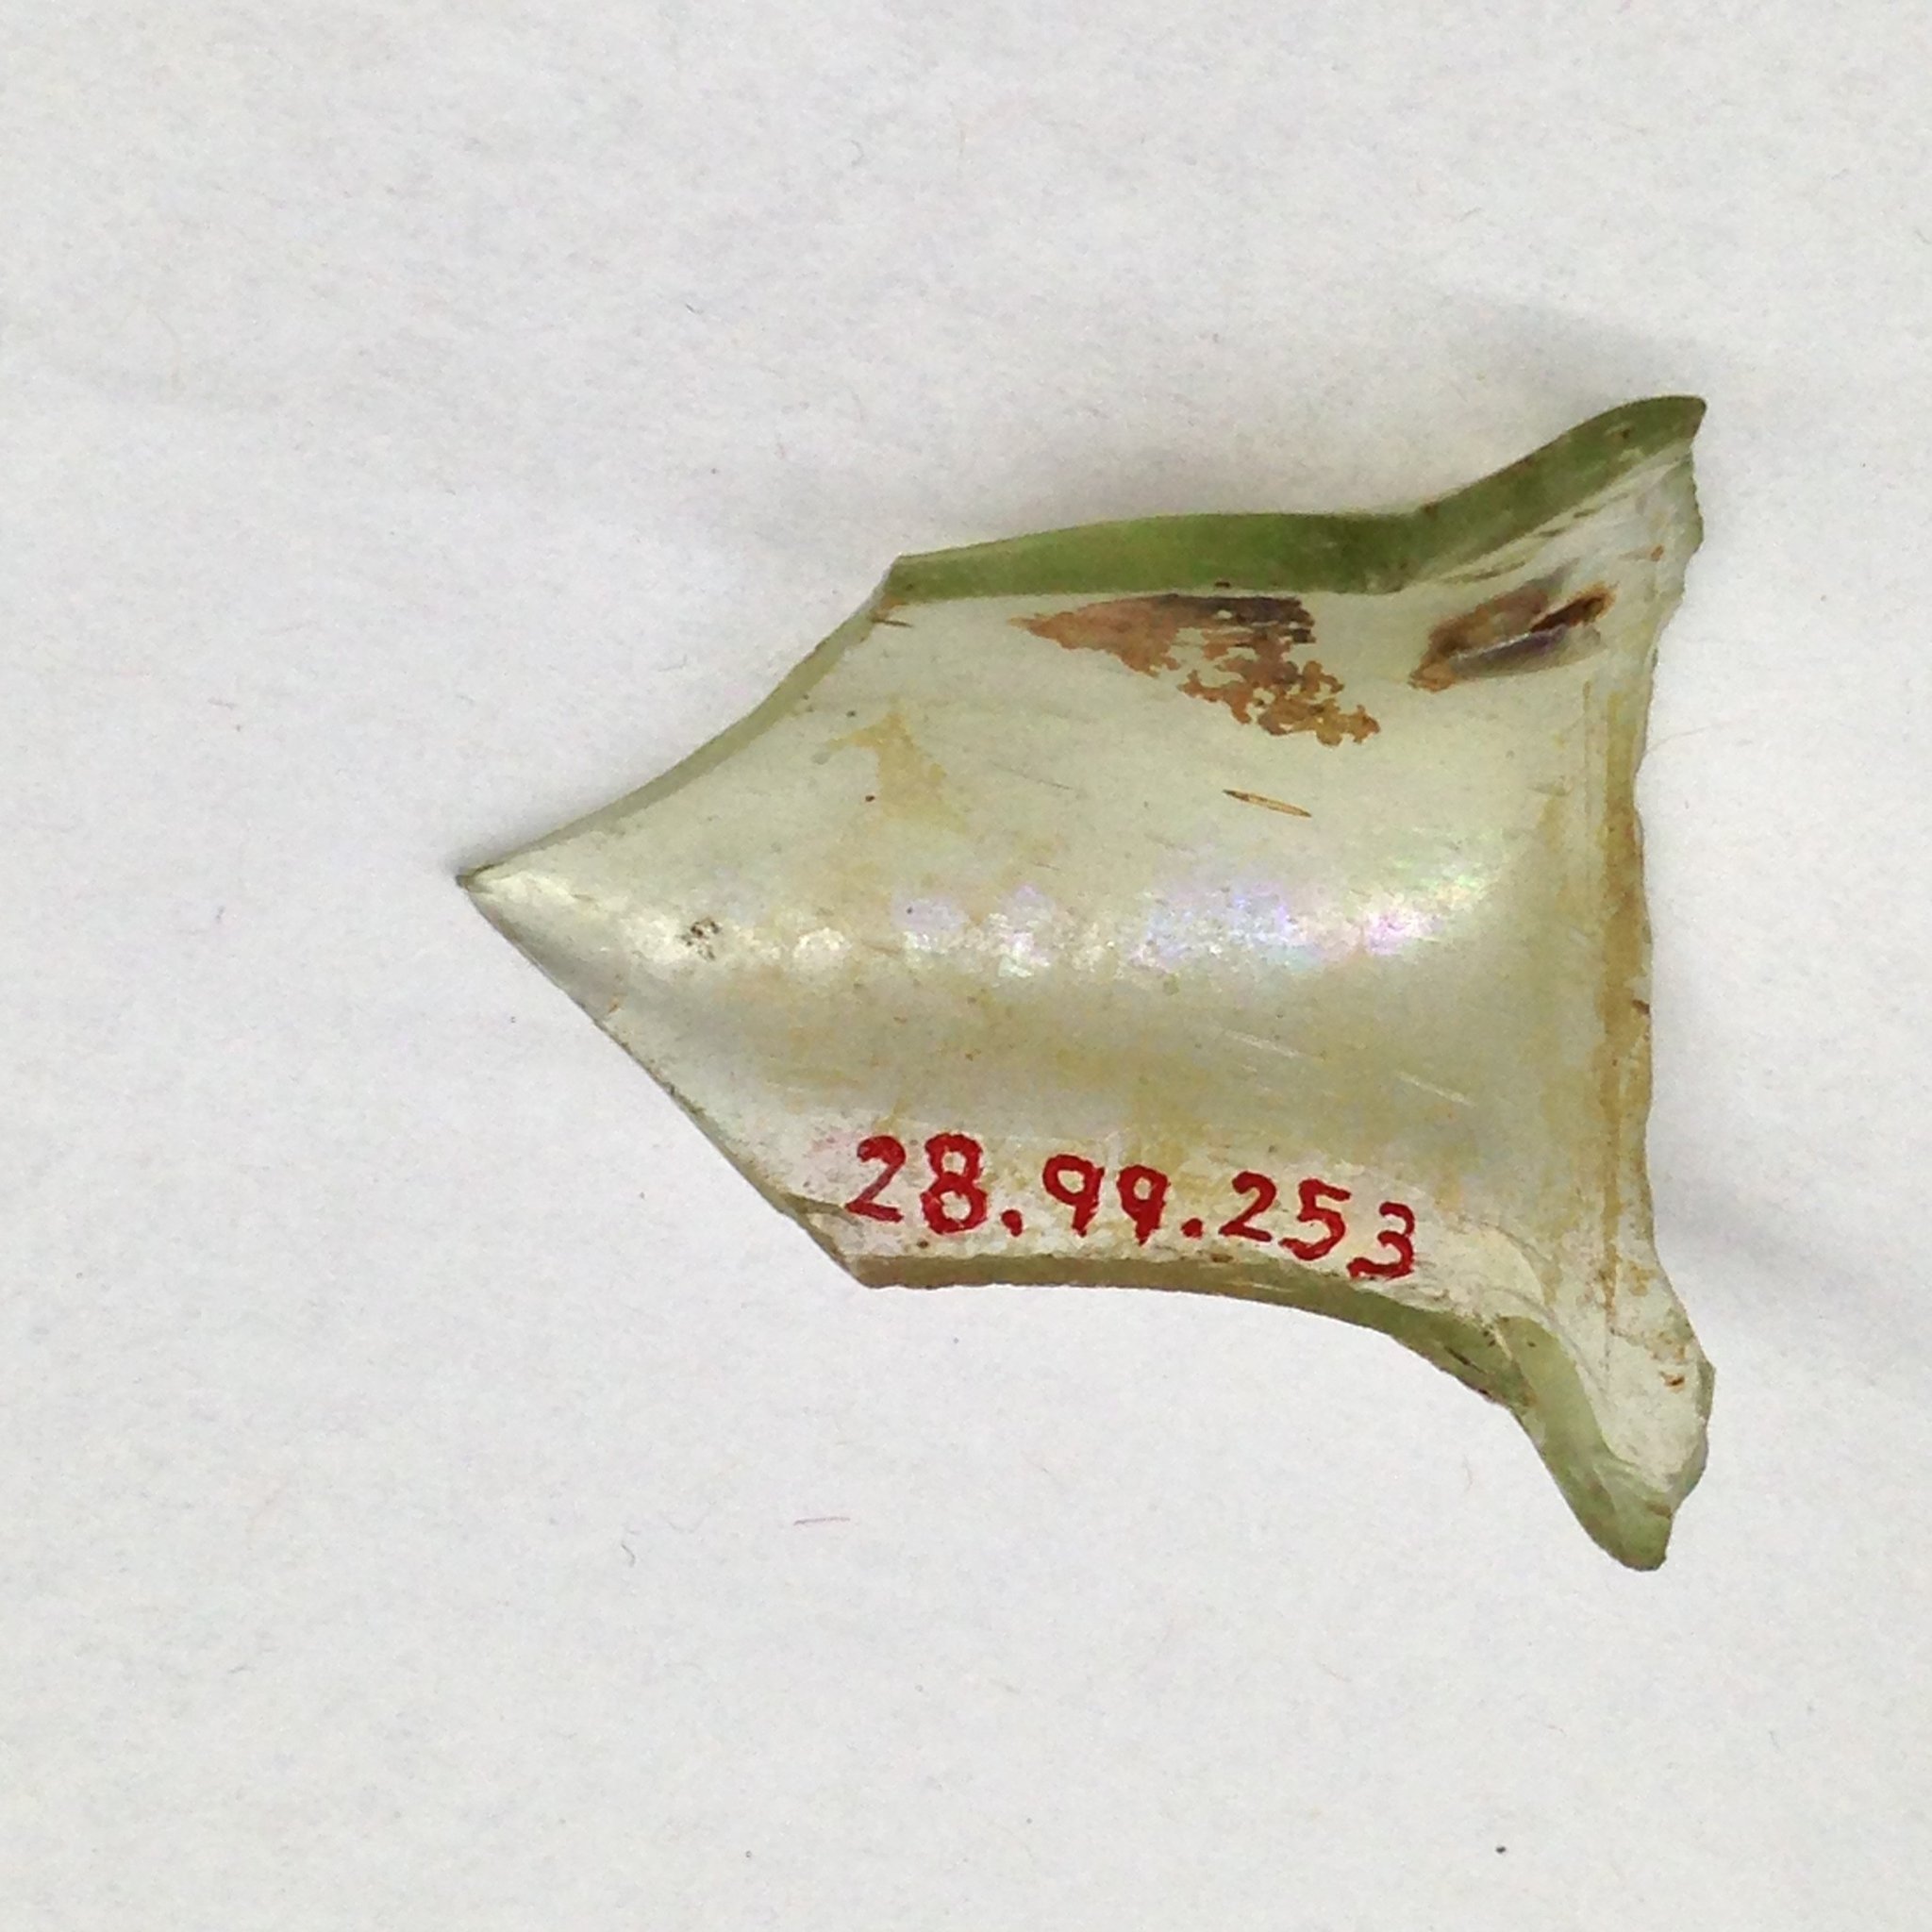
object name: fragment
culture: european or middle eastern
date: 1150-1250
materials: ceramic, glass